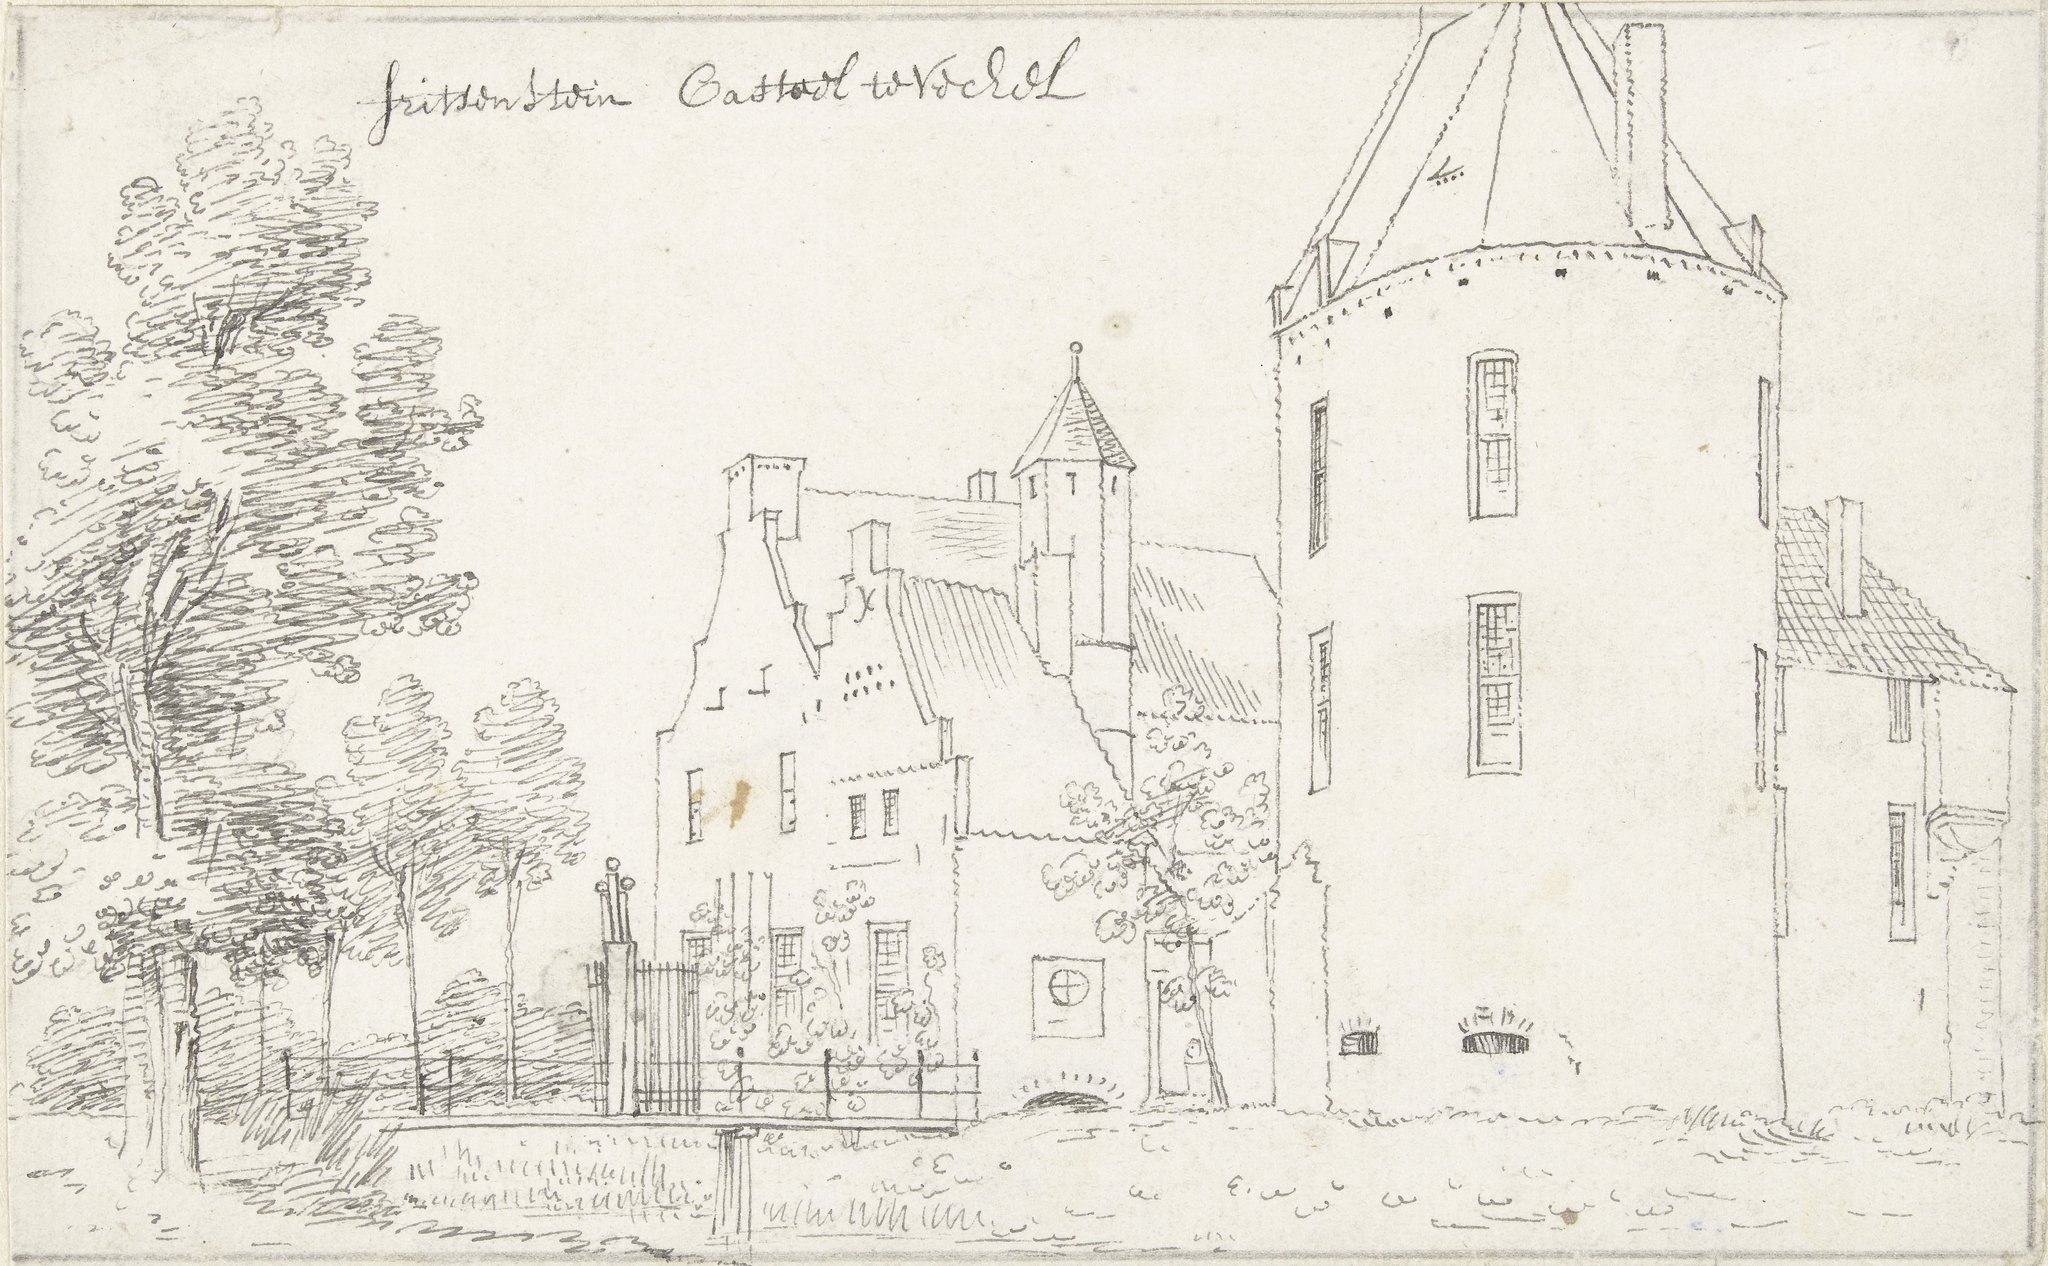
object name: drawing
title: Kasteel Frisselstein bij Veghel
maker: cornelis pronk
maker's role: draughtsman, painter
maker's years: 1691-1759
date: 1720-1740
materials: ink, paper, pencil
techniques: pen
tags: castle, veghel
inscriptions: inscription: ‘frissenstein Casteel te Vechel’